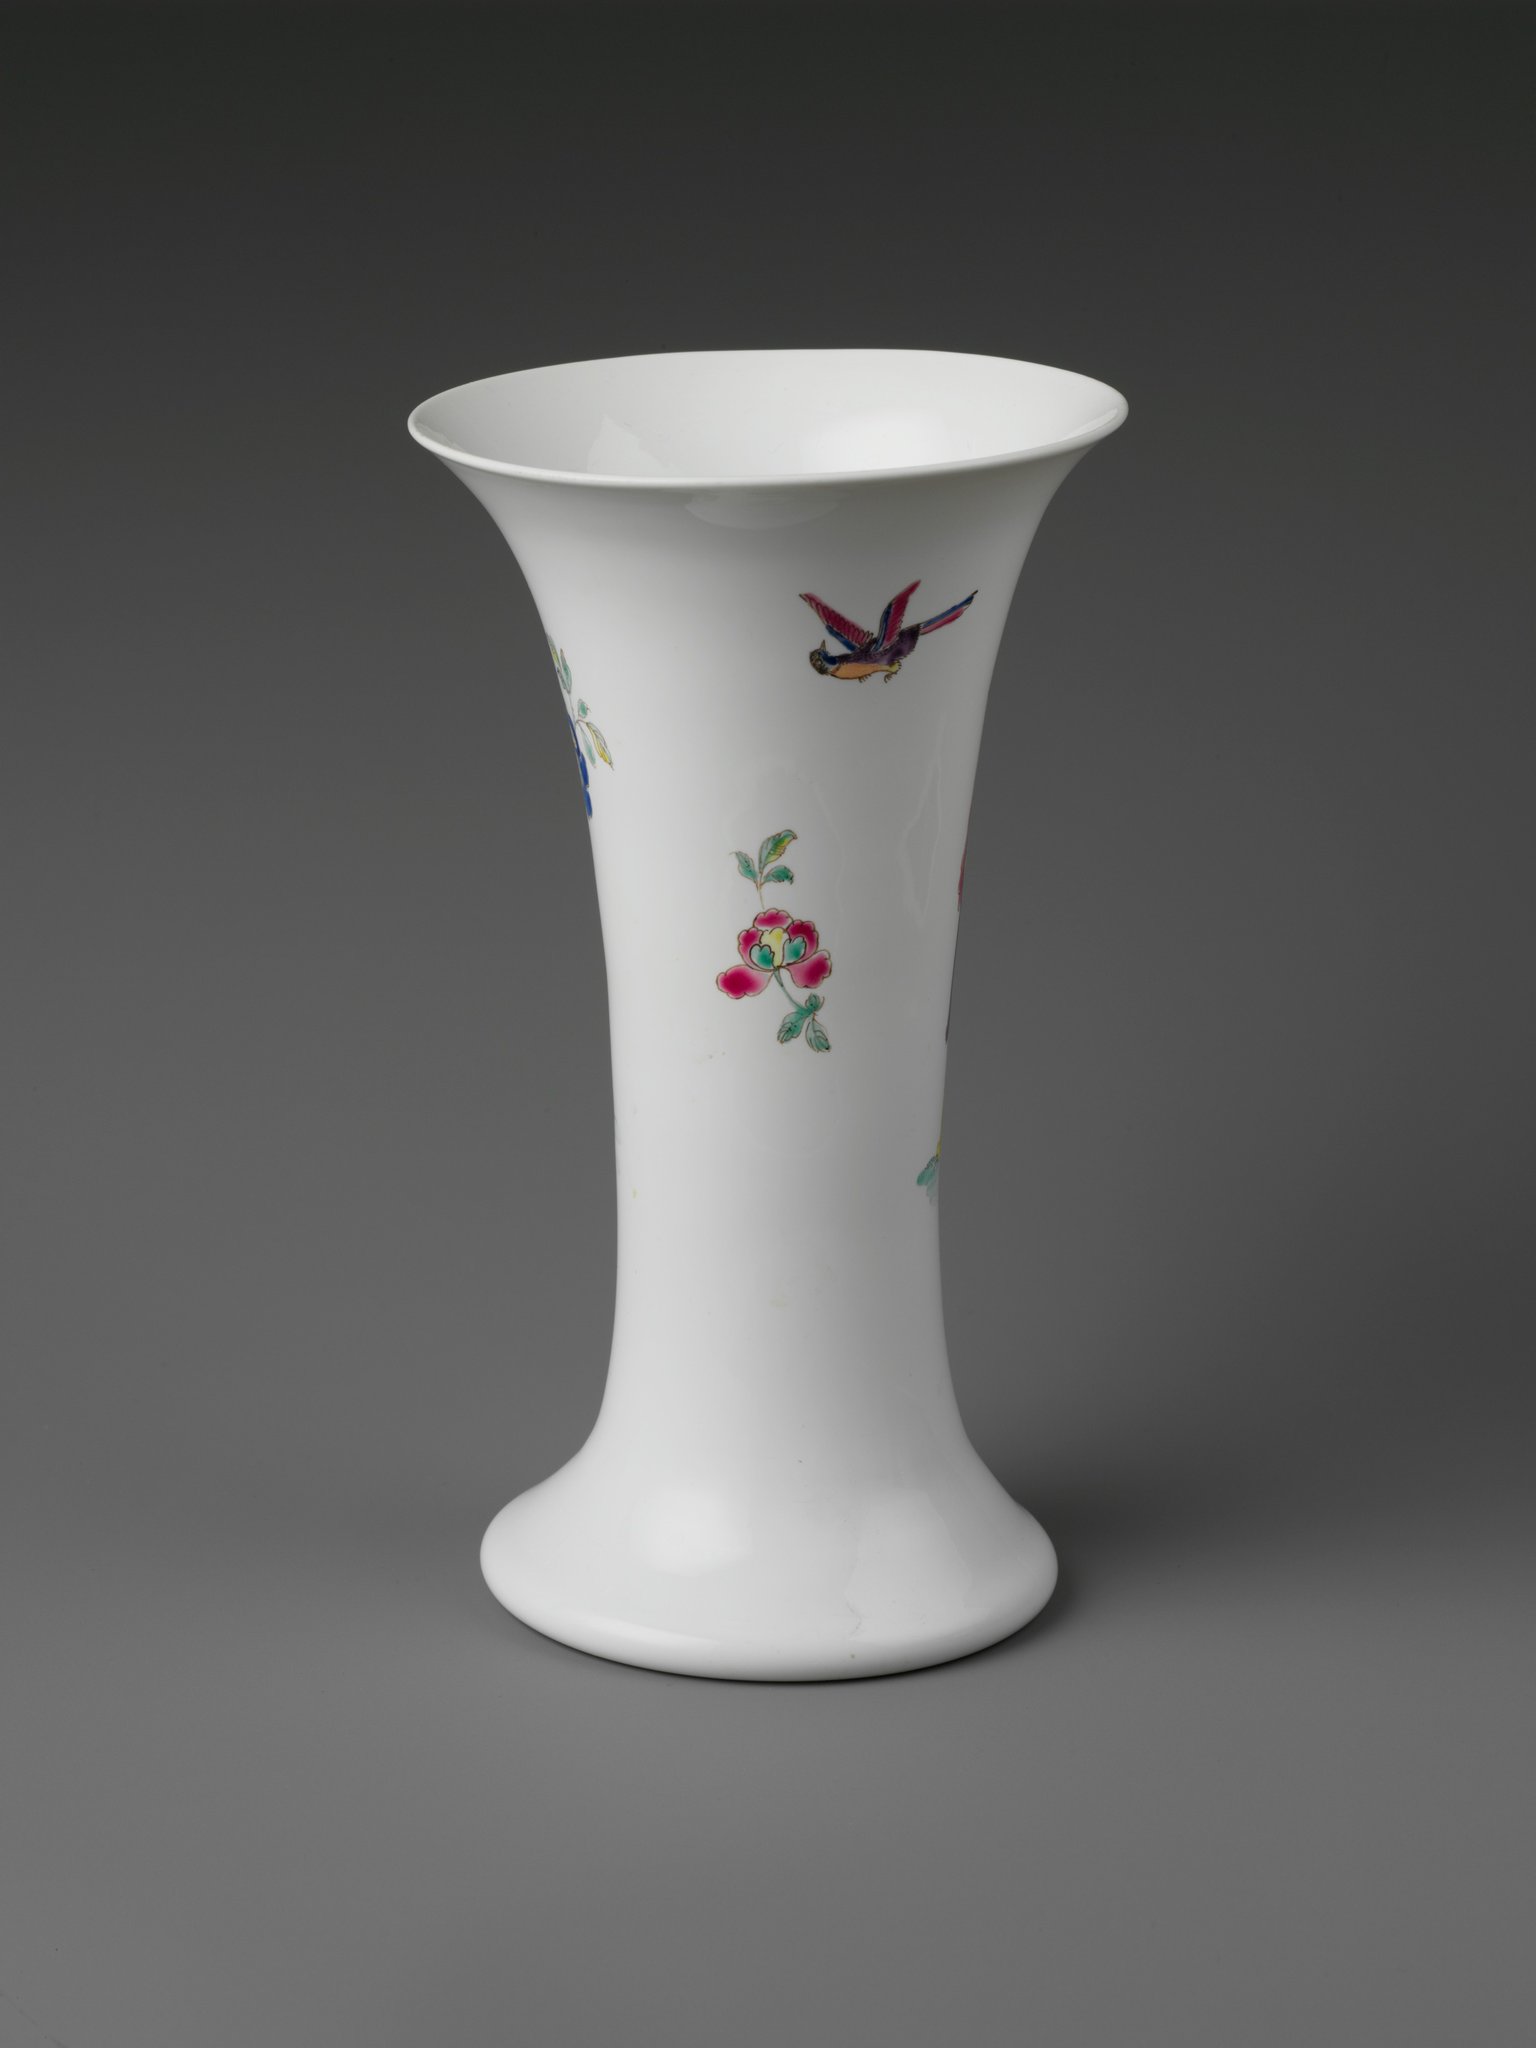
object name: beaker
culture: british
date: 1760-1765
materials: enamel, glass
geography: england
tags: birds,flowers